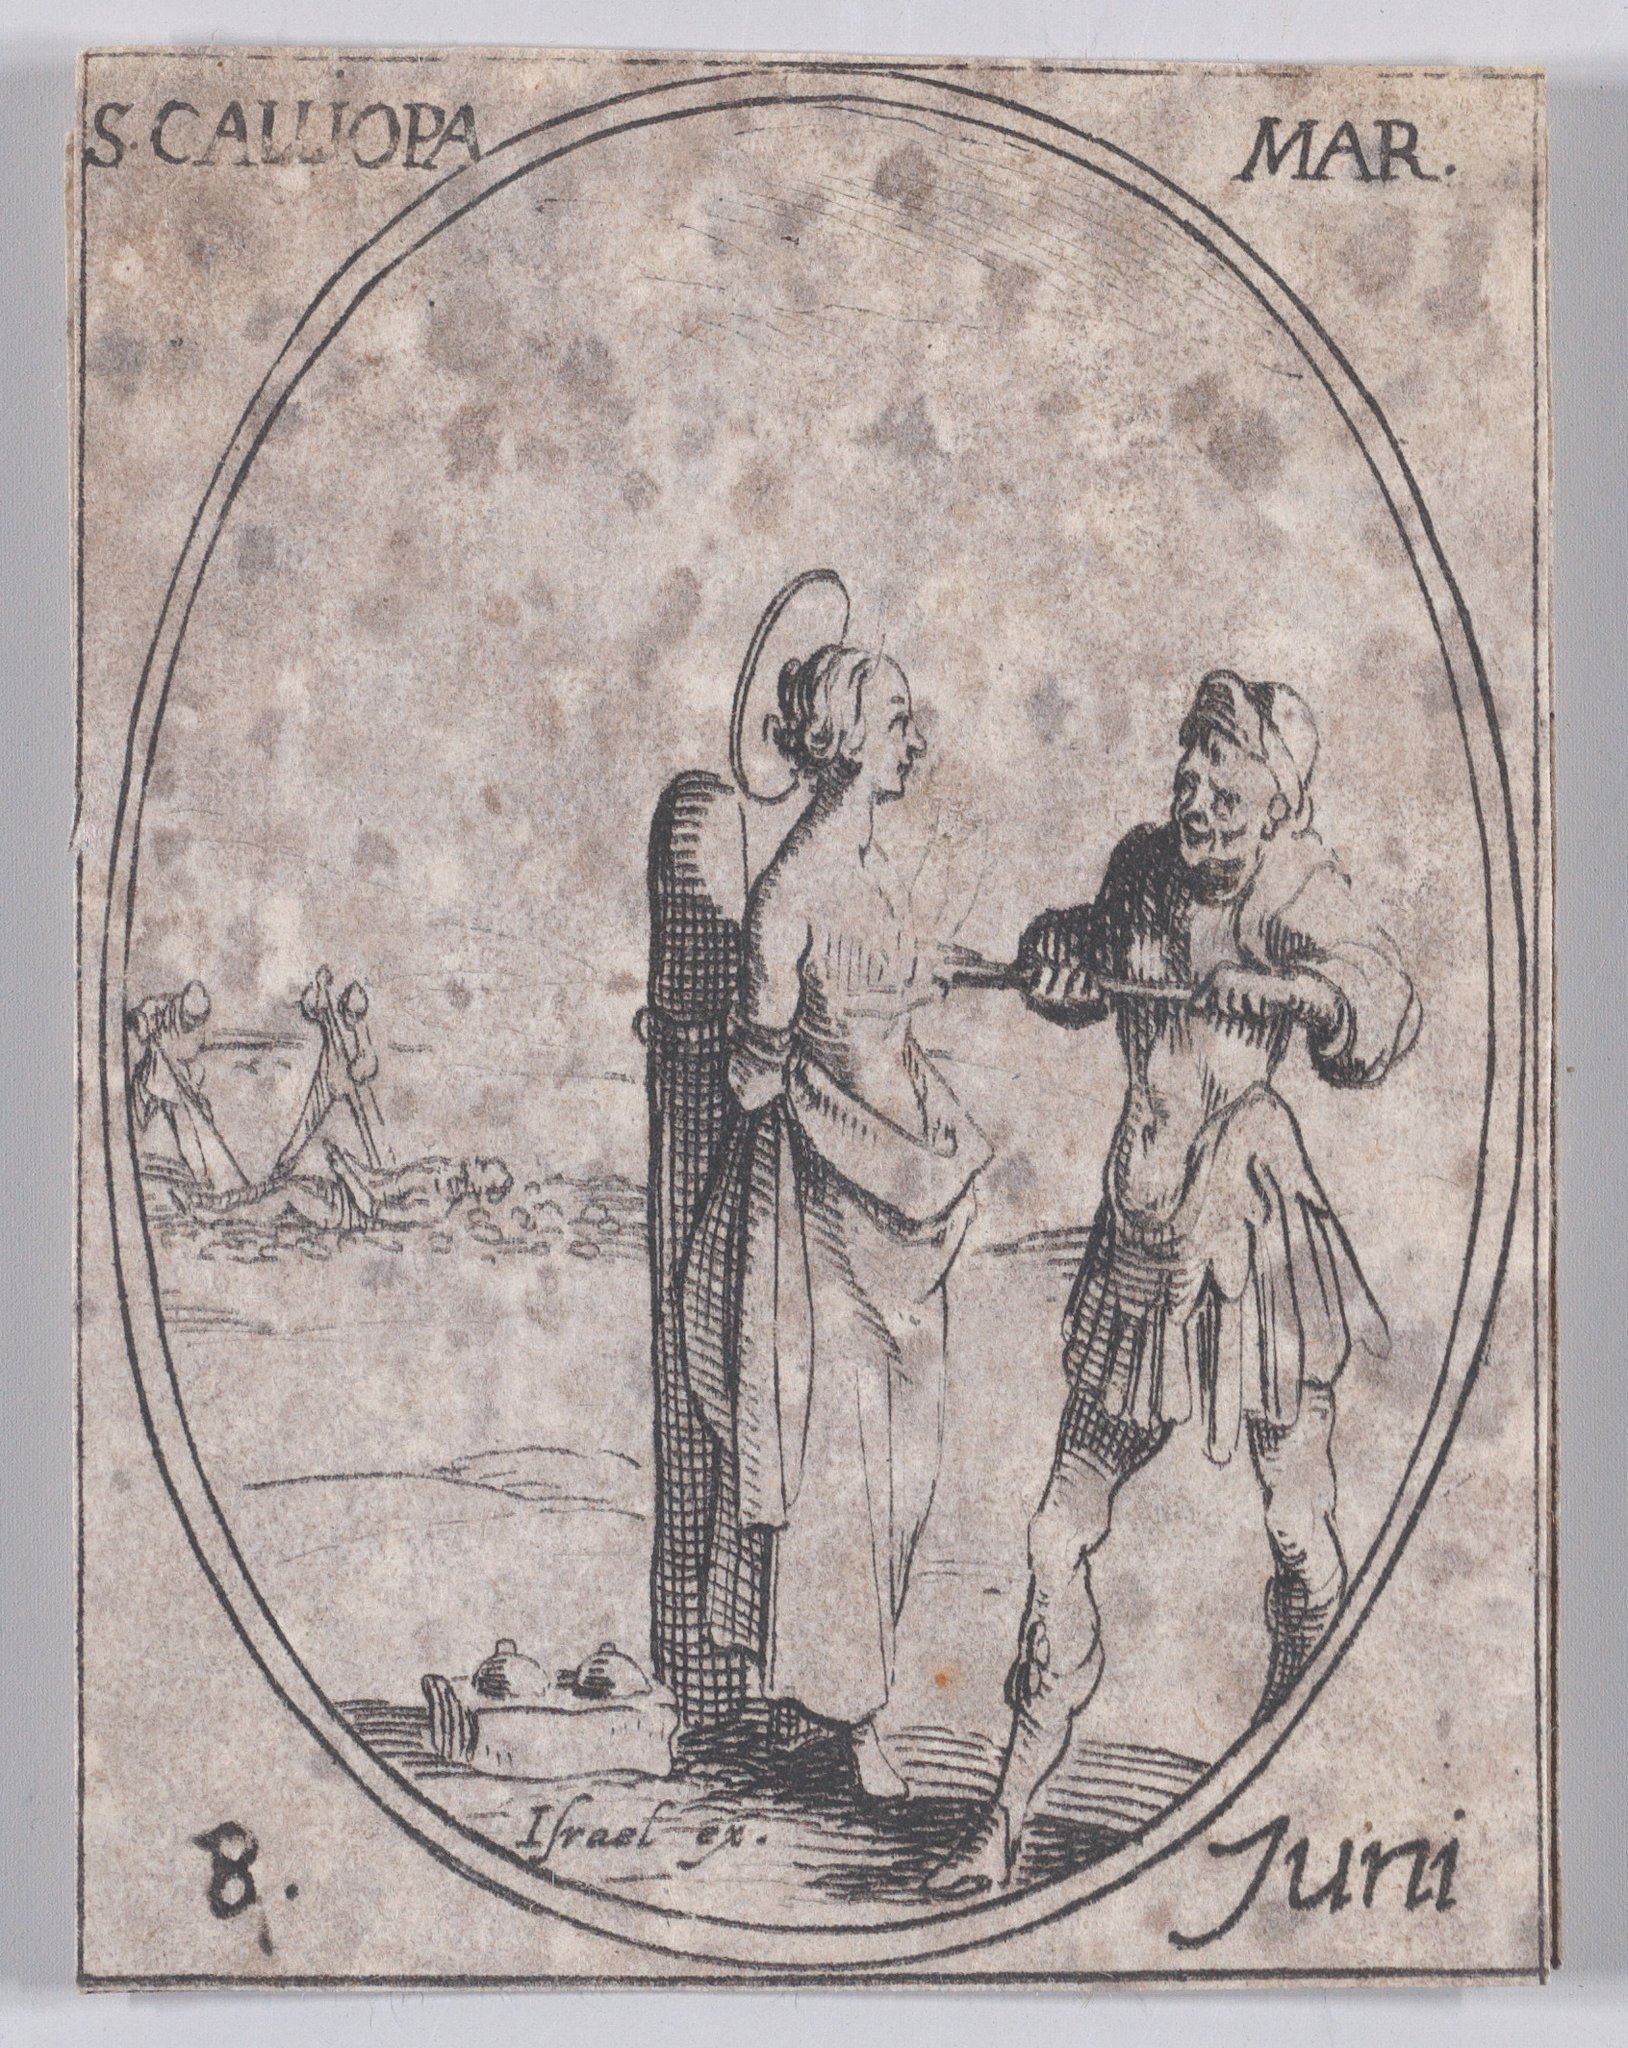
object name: print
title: Ste. Calliope, martyre (St. Calliope, Martyr), June 8th, from "Les Images De Tous Les Saincts et Saintes de L'Année" (Images of All of the Saints and Religious Events of the Year)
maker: jacques callot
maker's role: artist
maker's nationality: french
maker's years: 1592-1635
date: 1636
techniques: etching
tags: men,saints